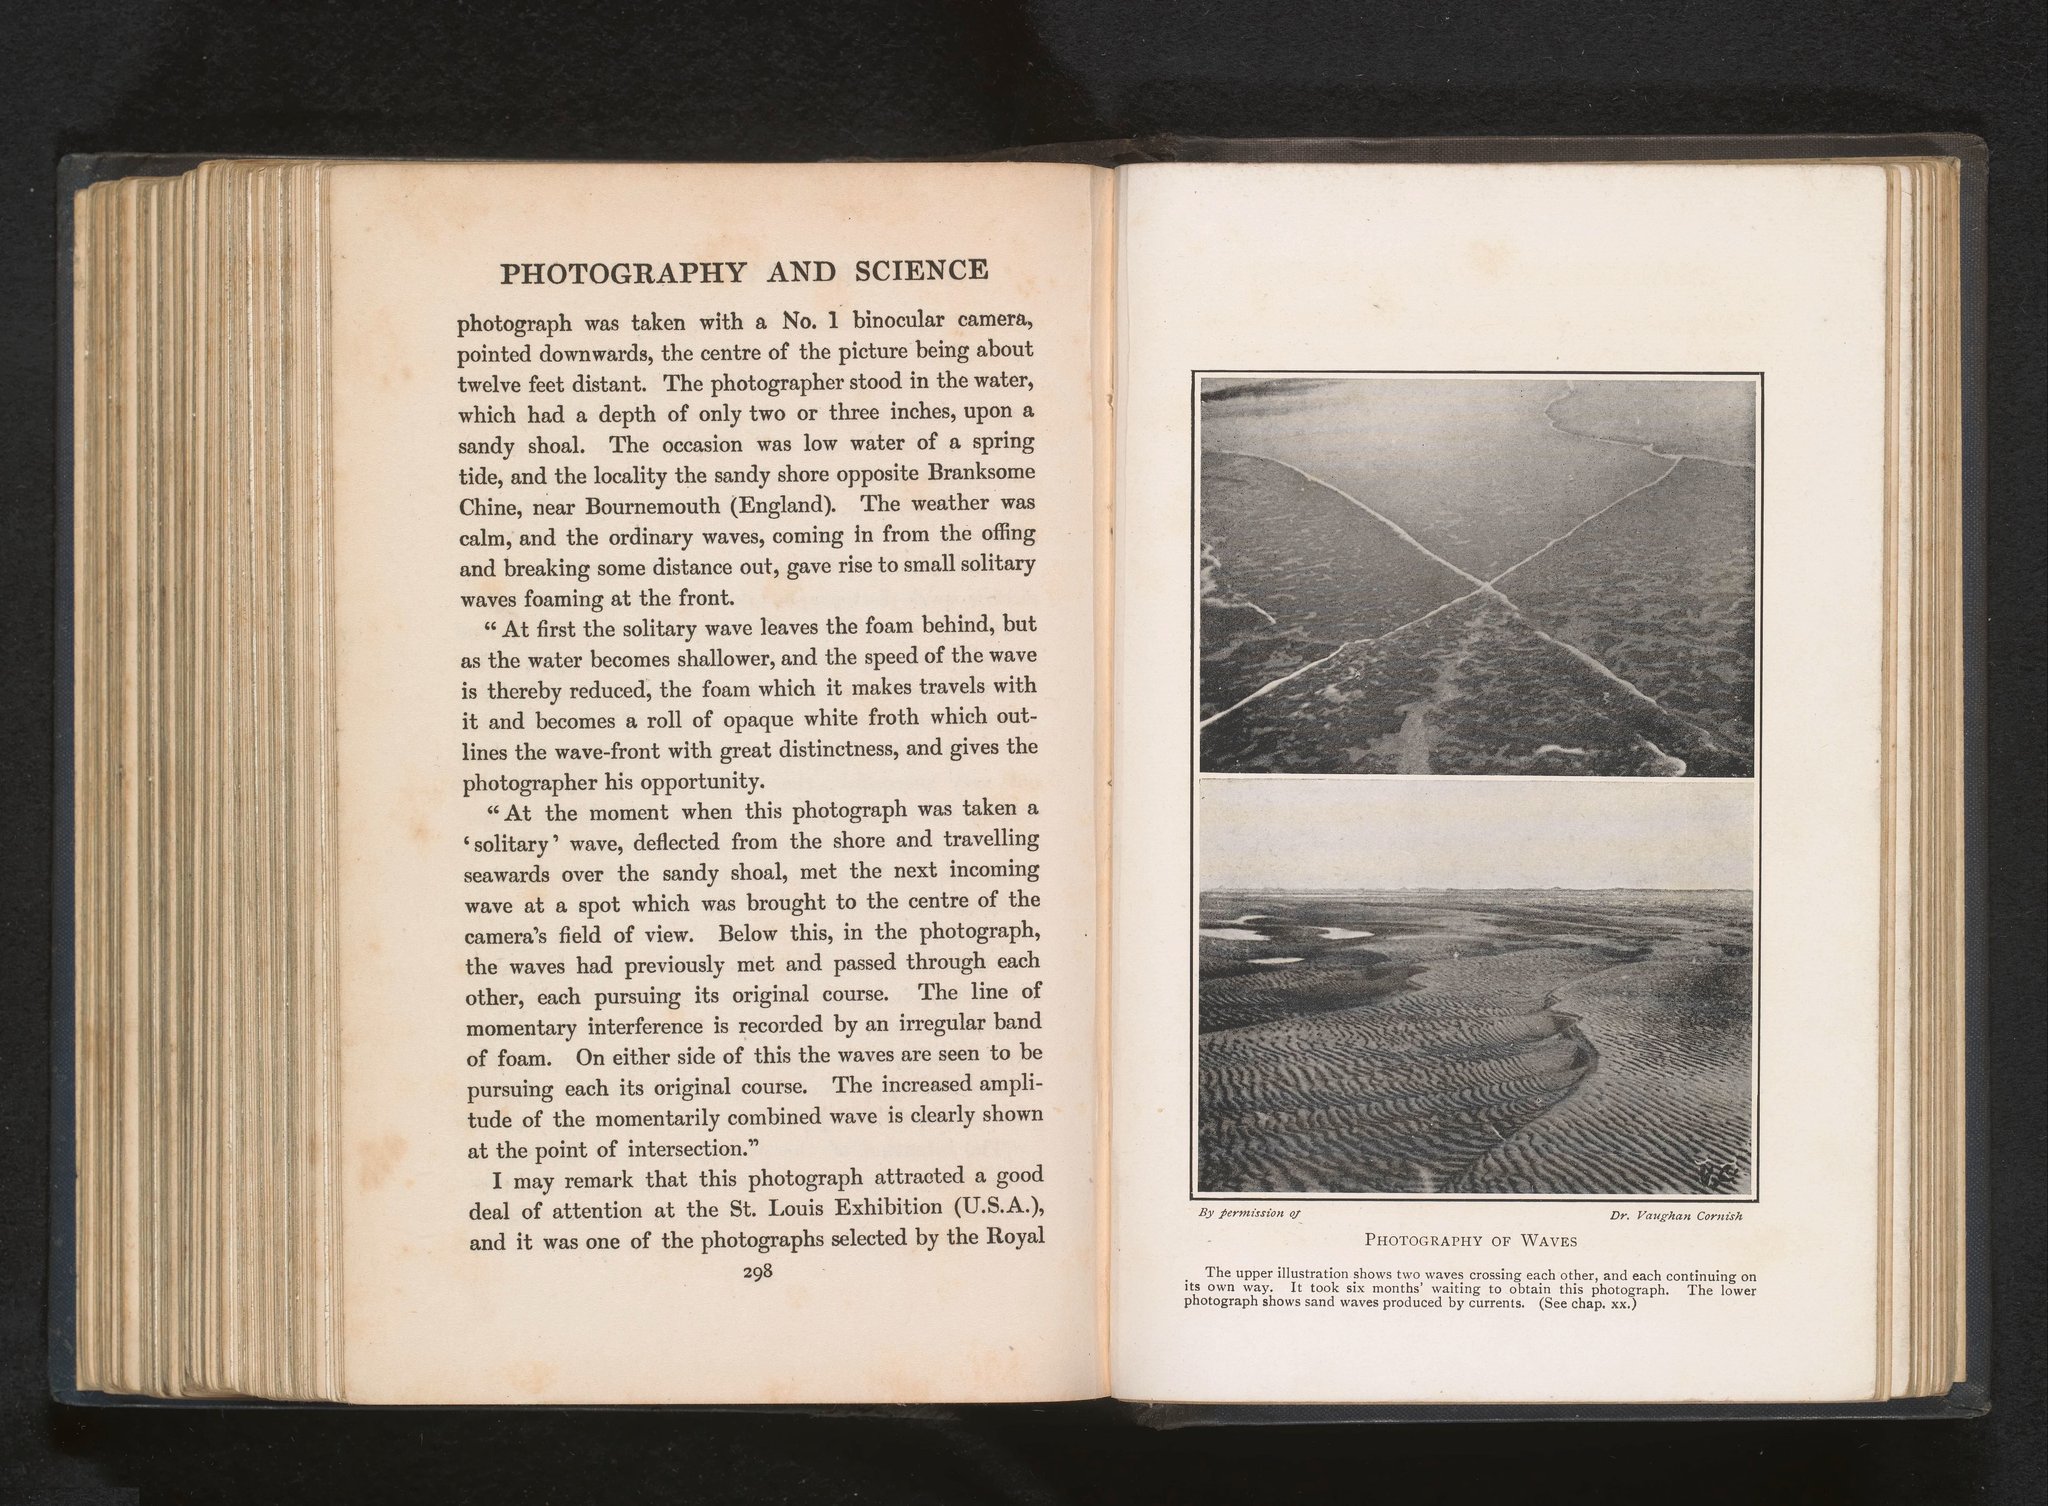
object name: page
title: Kruisende golven en een patroon dat de stroming heeft gemaakt in zand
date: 1898-1908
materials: paper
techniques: autotype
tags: wave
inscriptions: inscription: ‘The upper illustration shows two waves crossing each other, and each continuing on its own way. It took six months' waiting to obtain this photograph. The lower photograph shows sand waves produced by currents. (See chap. xx.)’